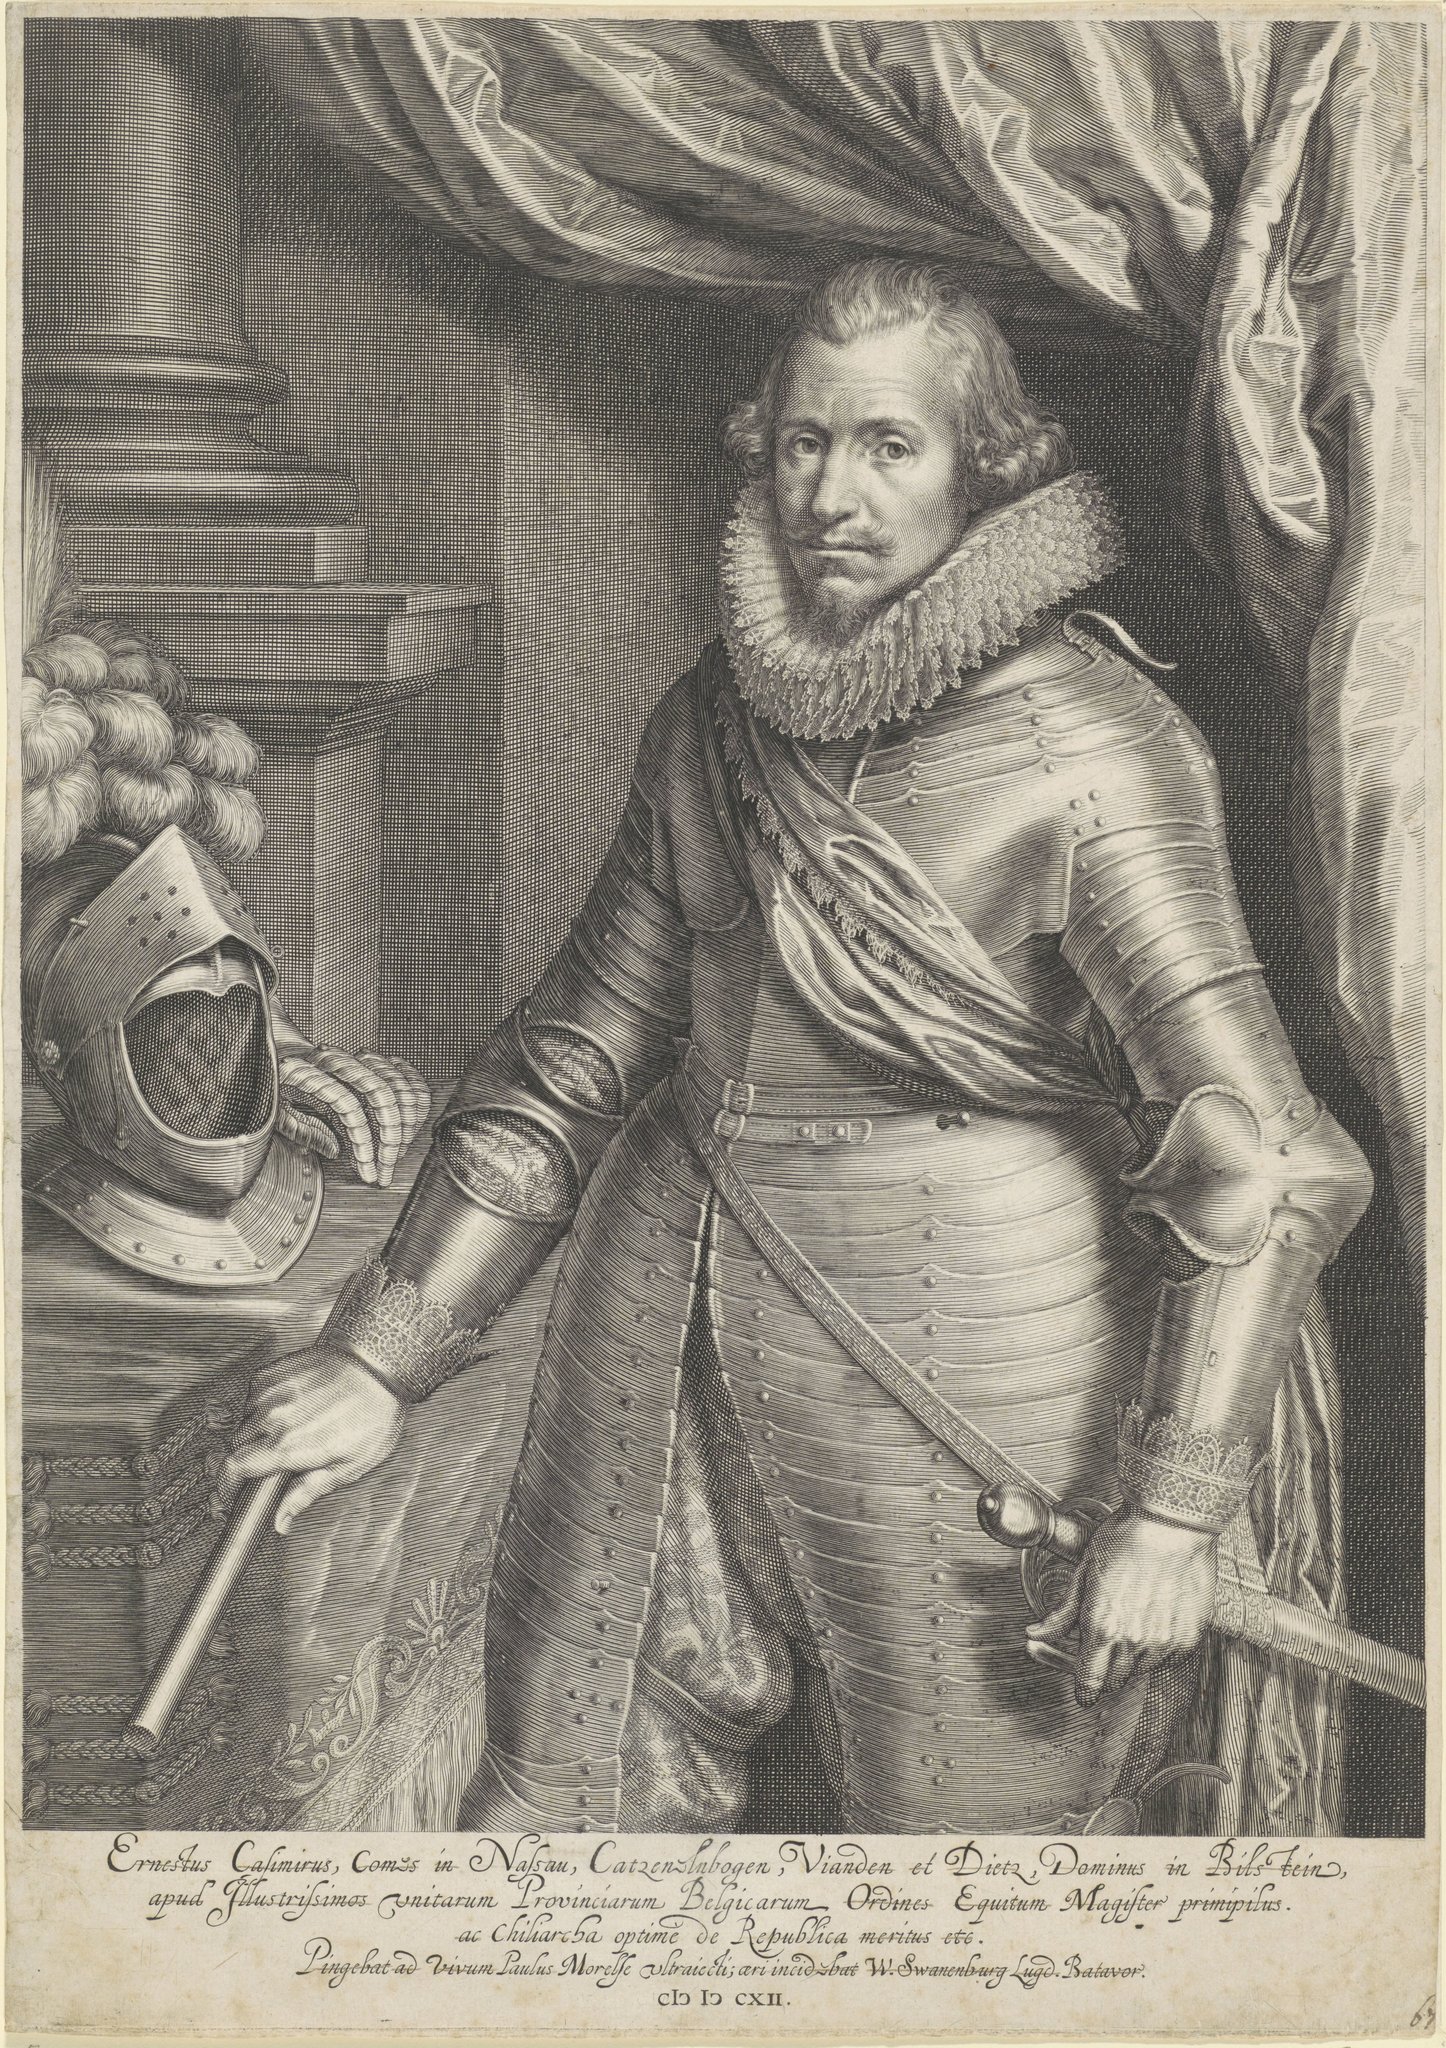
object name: print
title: Portret van Ernst Casimir, graaf van Nassau-Dietz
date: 1612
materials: paper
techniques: engraving, etching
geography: leiden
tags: ernst casimir graaf van nassau-dietz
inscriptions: collector's mark: Lugt 963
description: De hier vermelde titel verwijst naar de hoogst verkregen titel van de geportretteerde, niet per se naar de titel die de geportretteerde op deze voorstelling draagt.